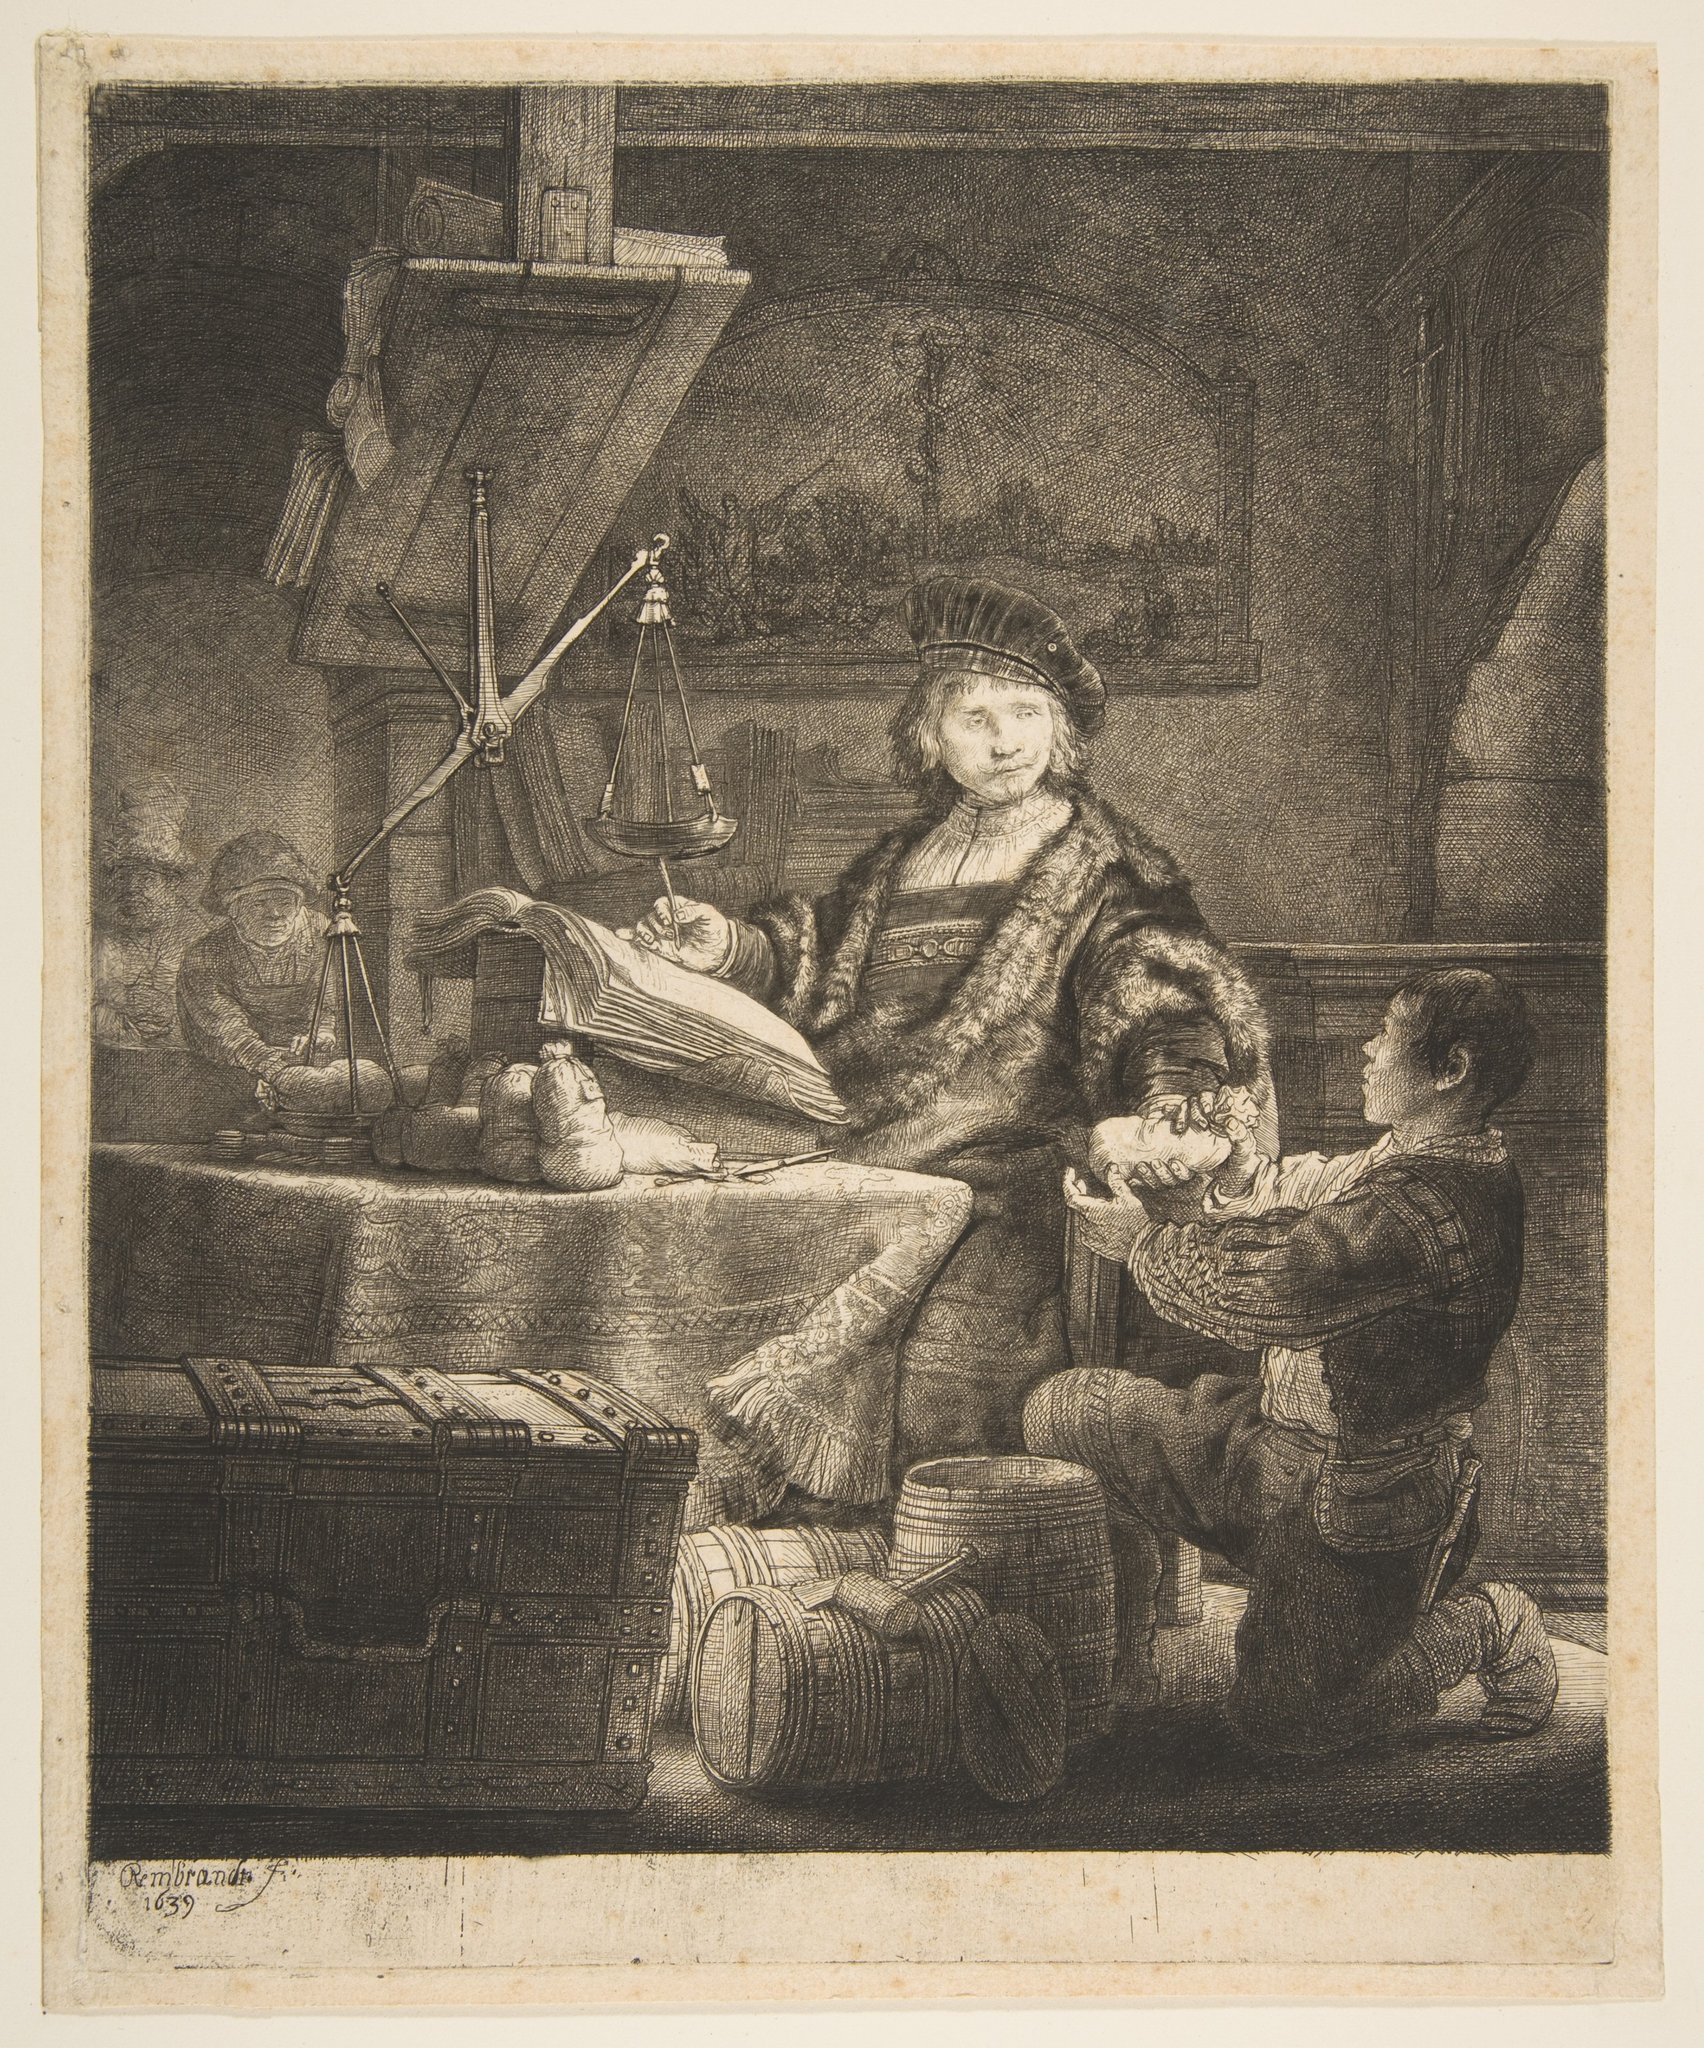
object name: print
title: Jan Uytenbogaert (The Gold Weigher)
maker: rembrandt van rijn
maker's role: artist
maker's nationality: dutch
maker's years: 1606-1669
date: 1639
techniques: drypoint, etching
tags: books,men,scales,tables